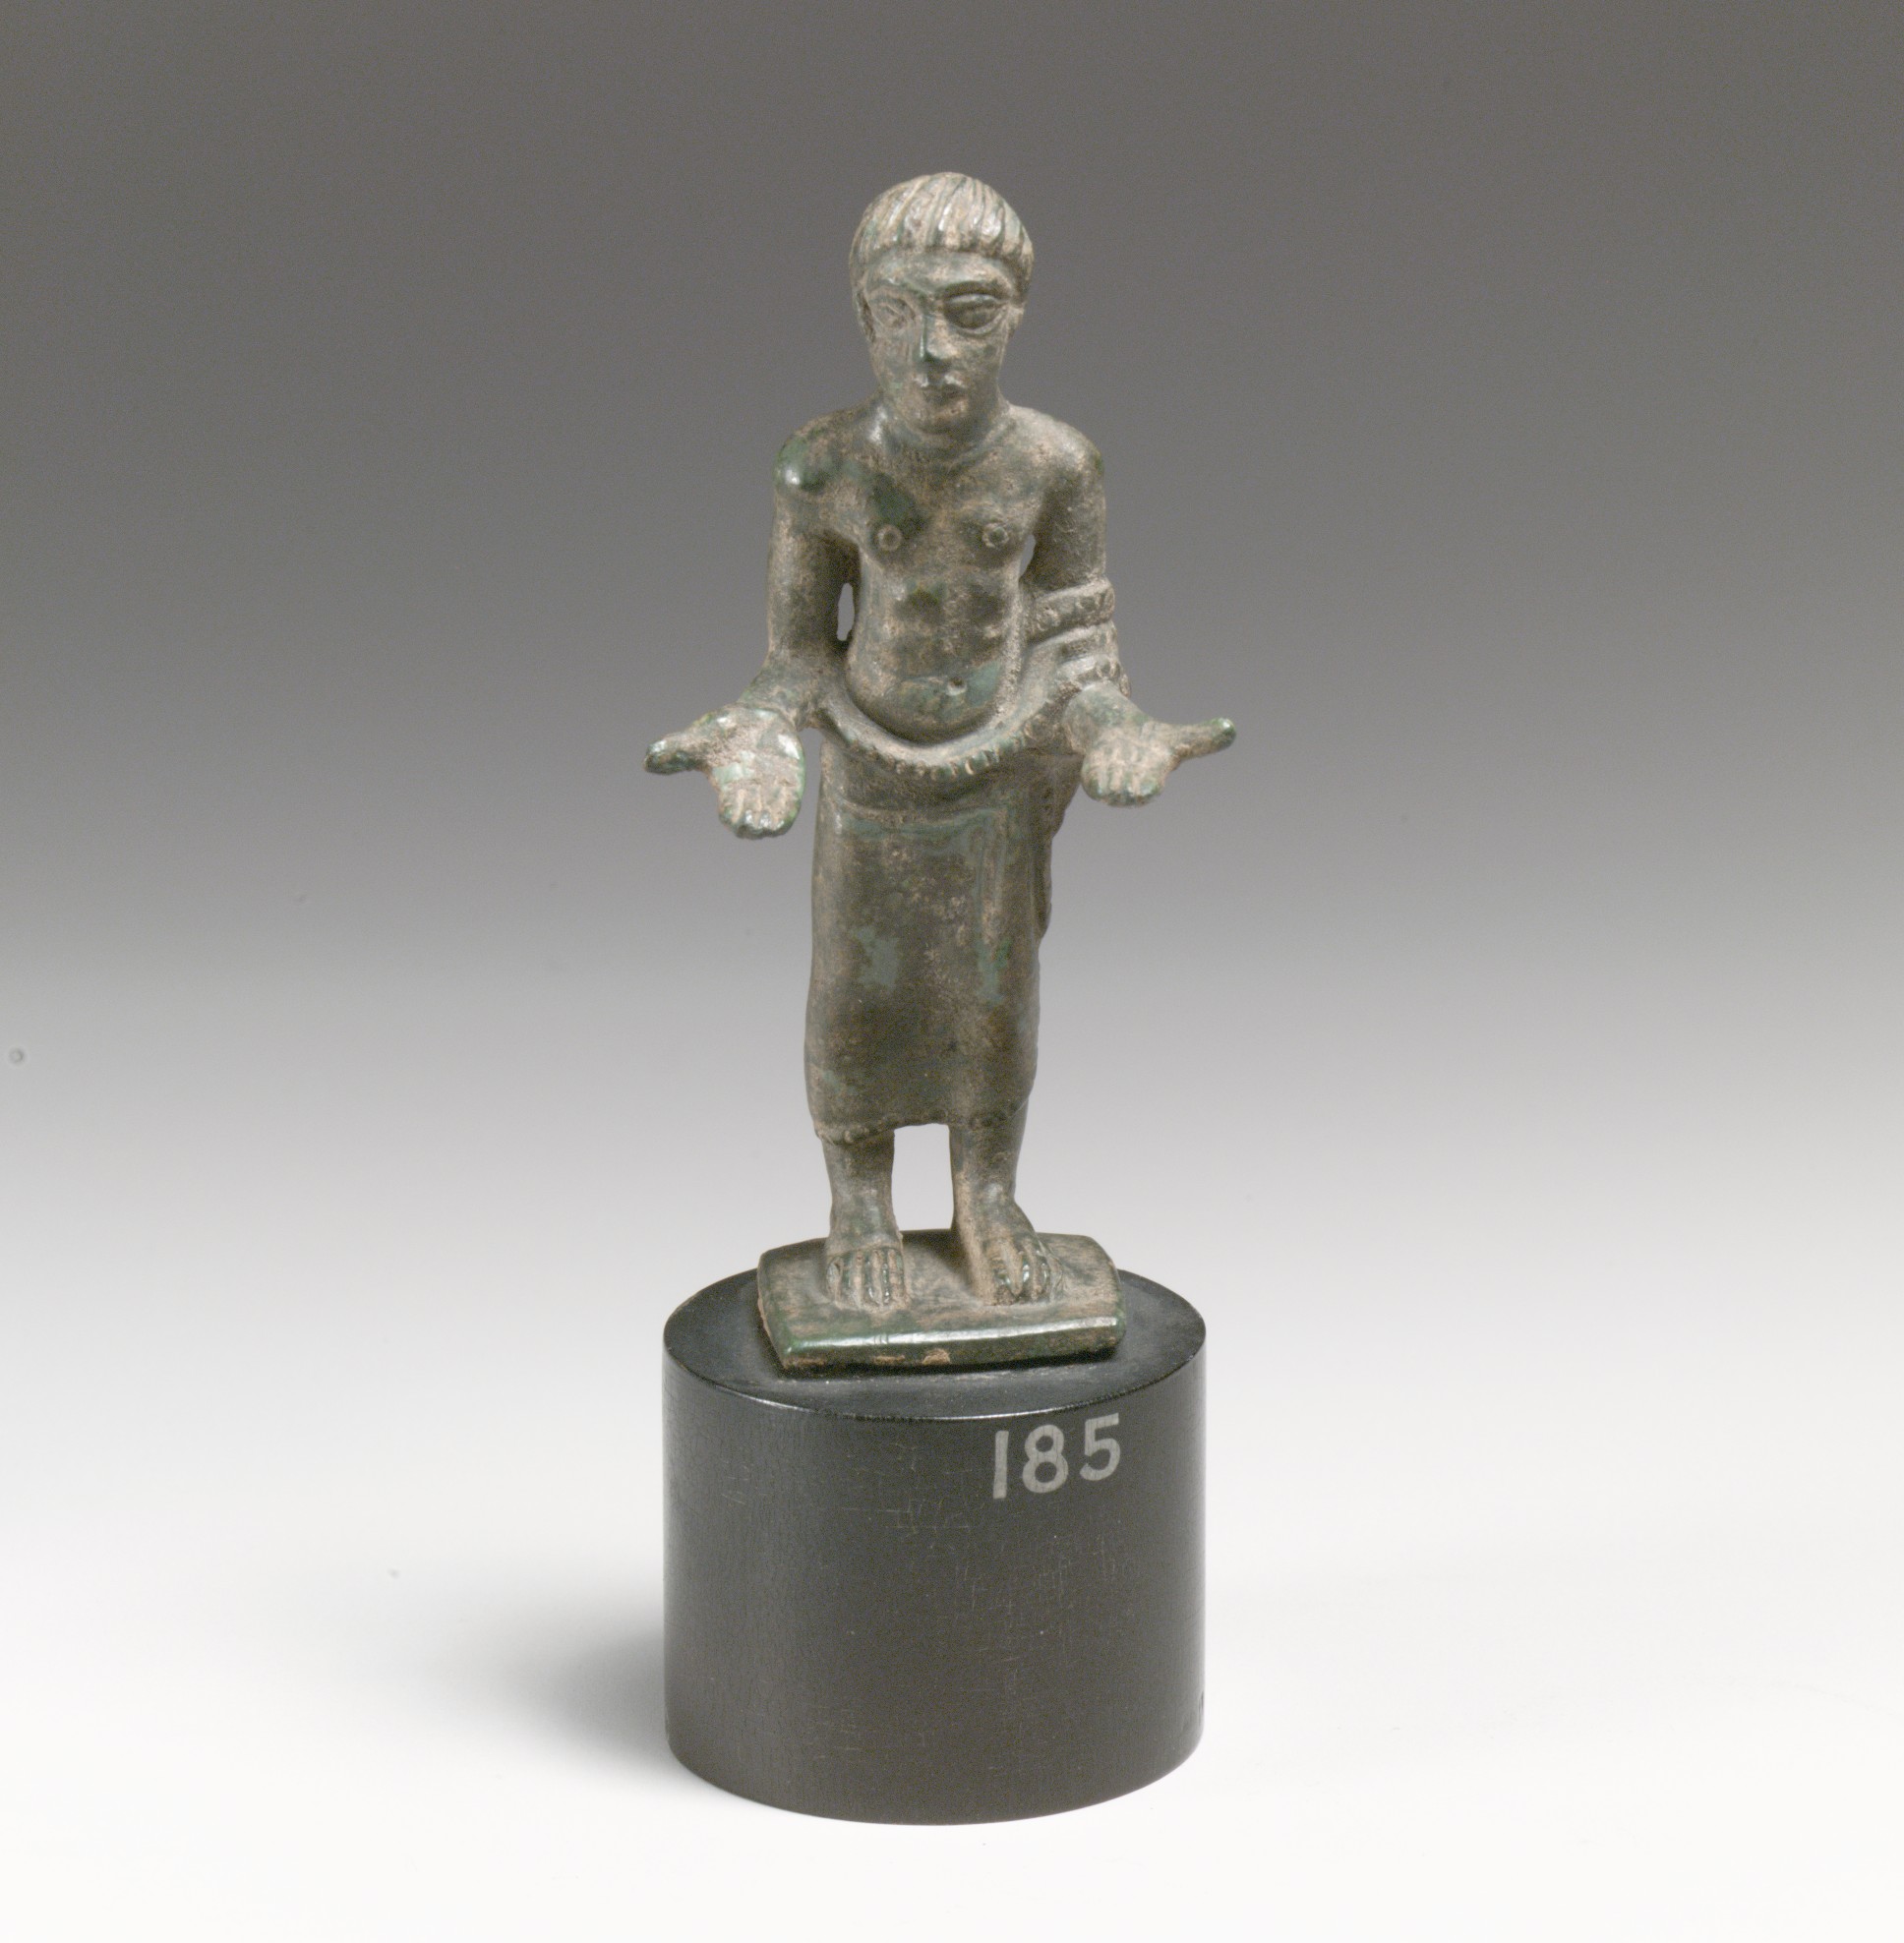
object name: statuette of a man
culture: italic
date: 500-301 BCE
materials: bronze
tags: men